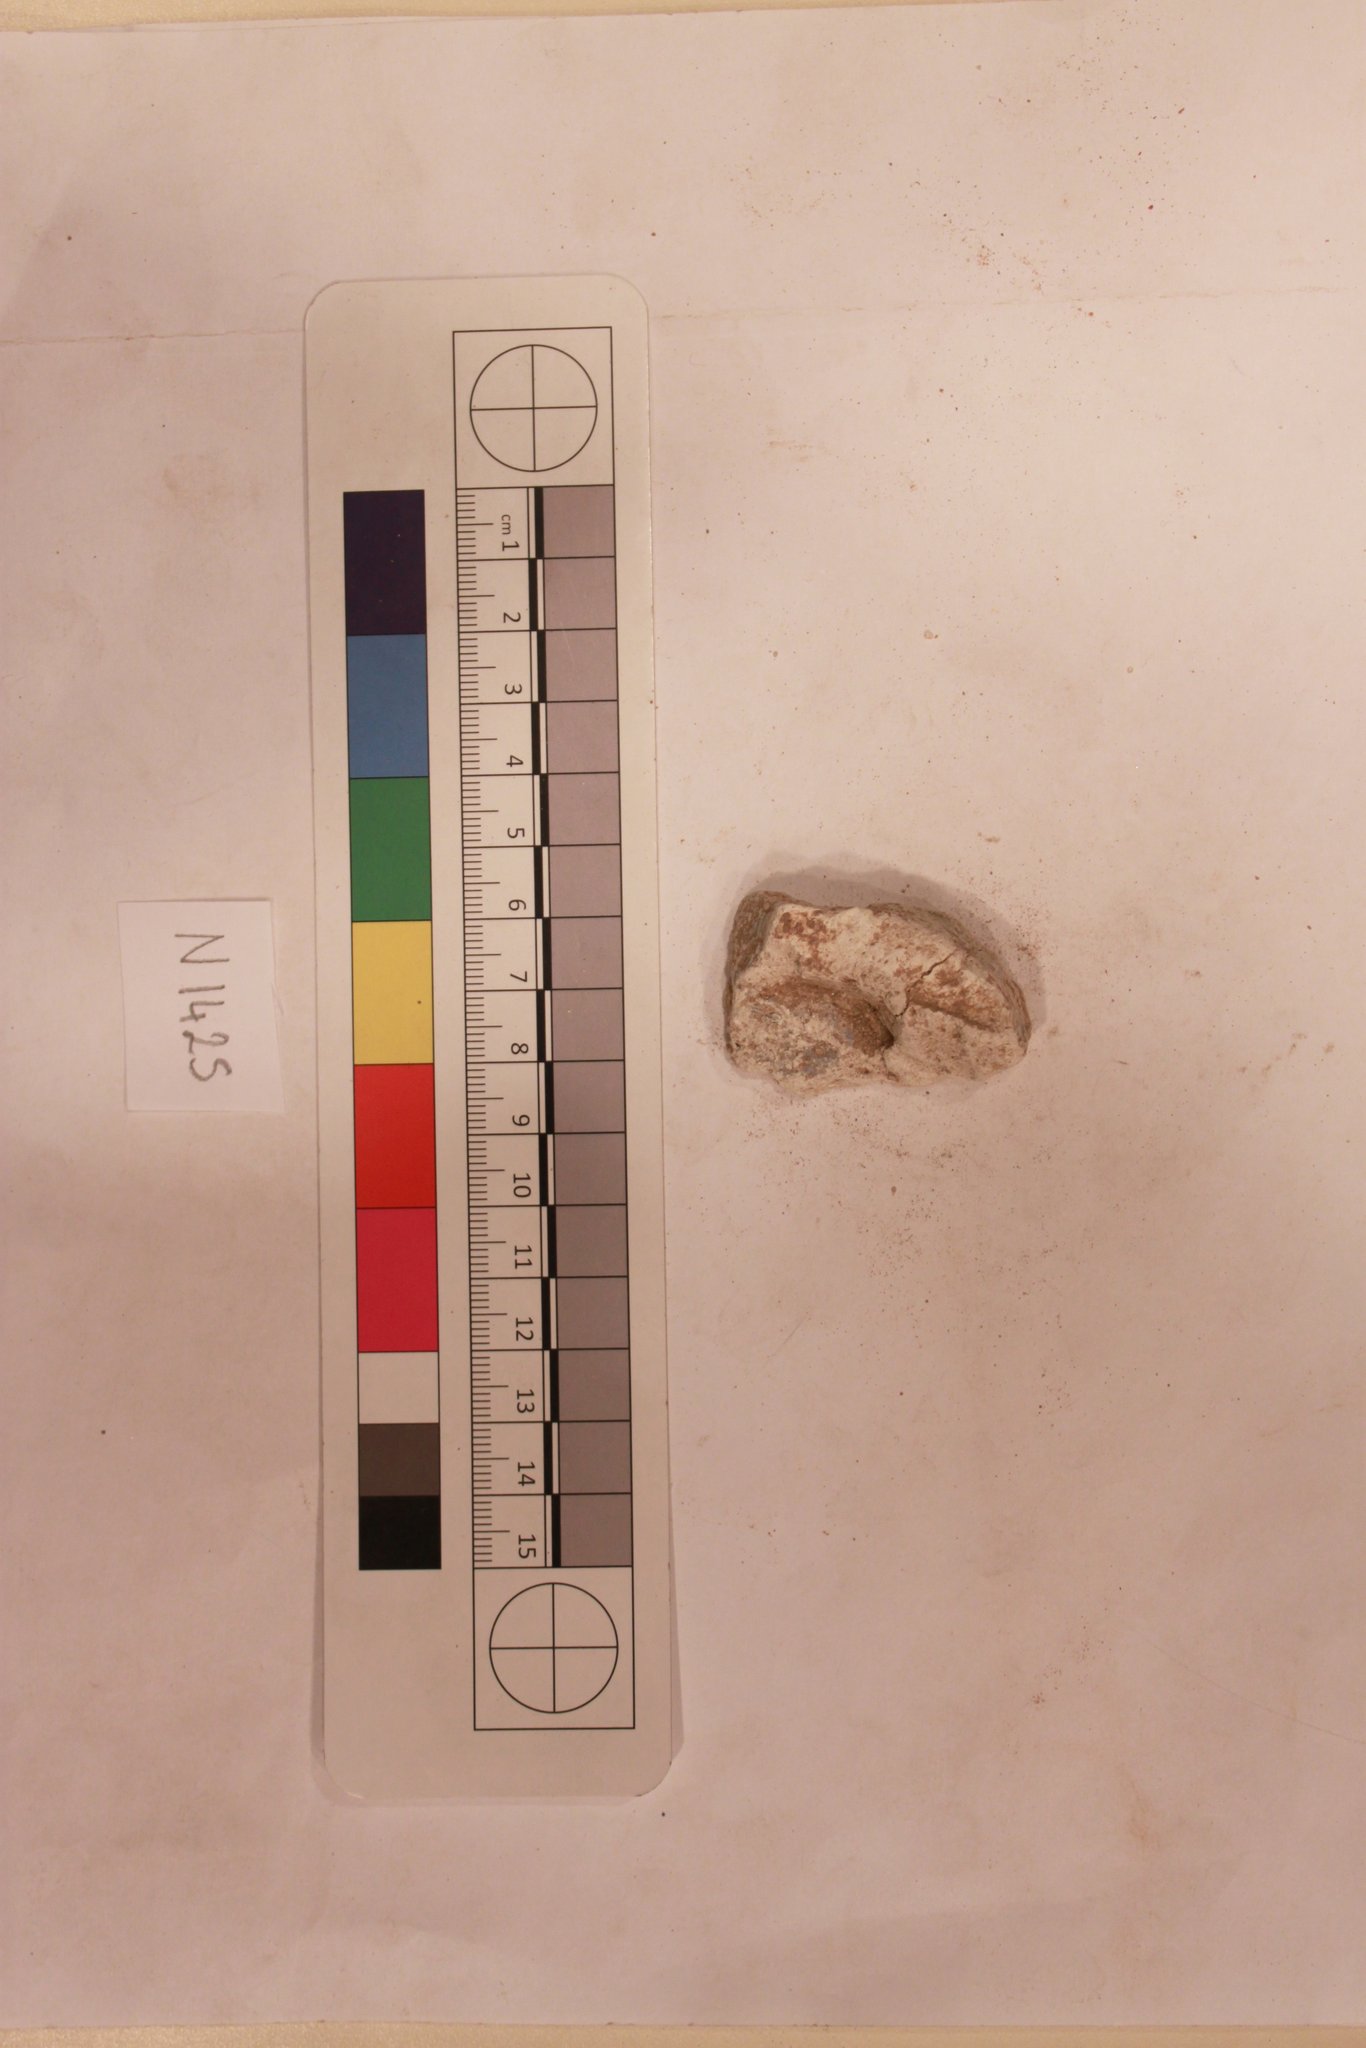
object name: fragment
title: Stucco Fragment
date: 701-1200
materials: plaster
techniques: carving, painting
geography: iran